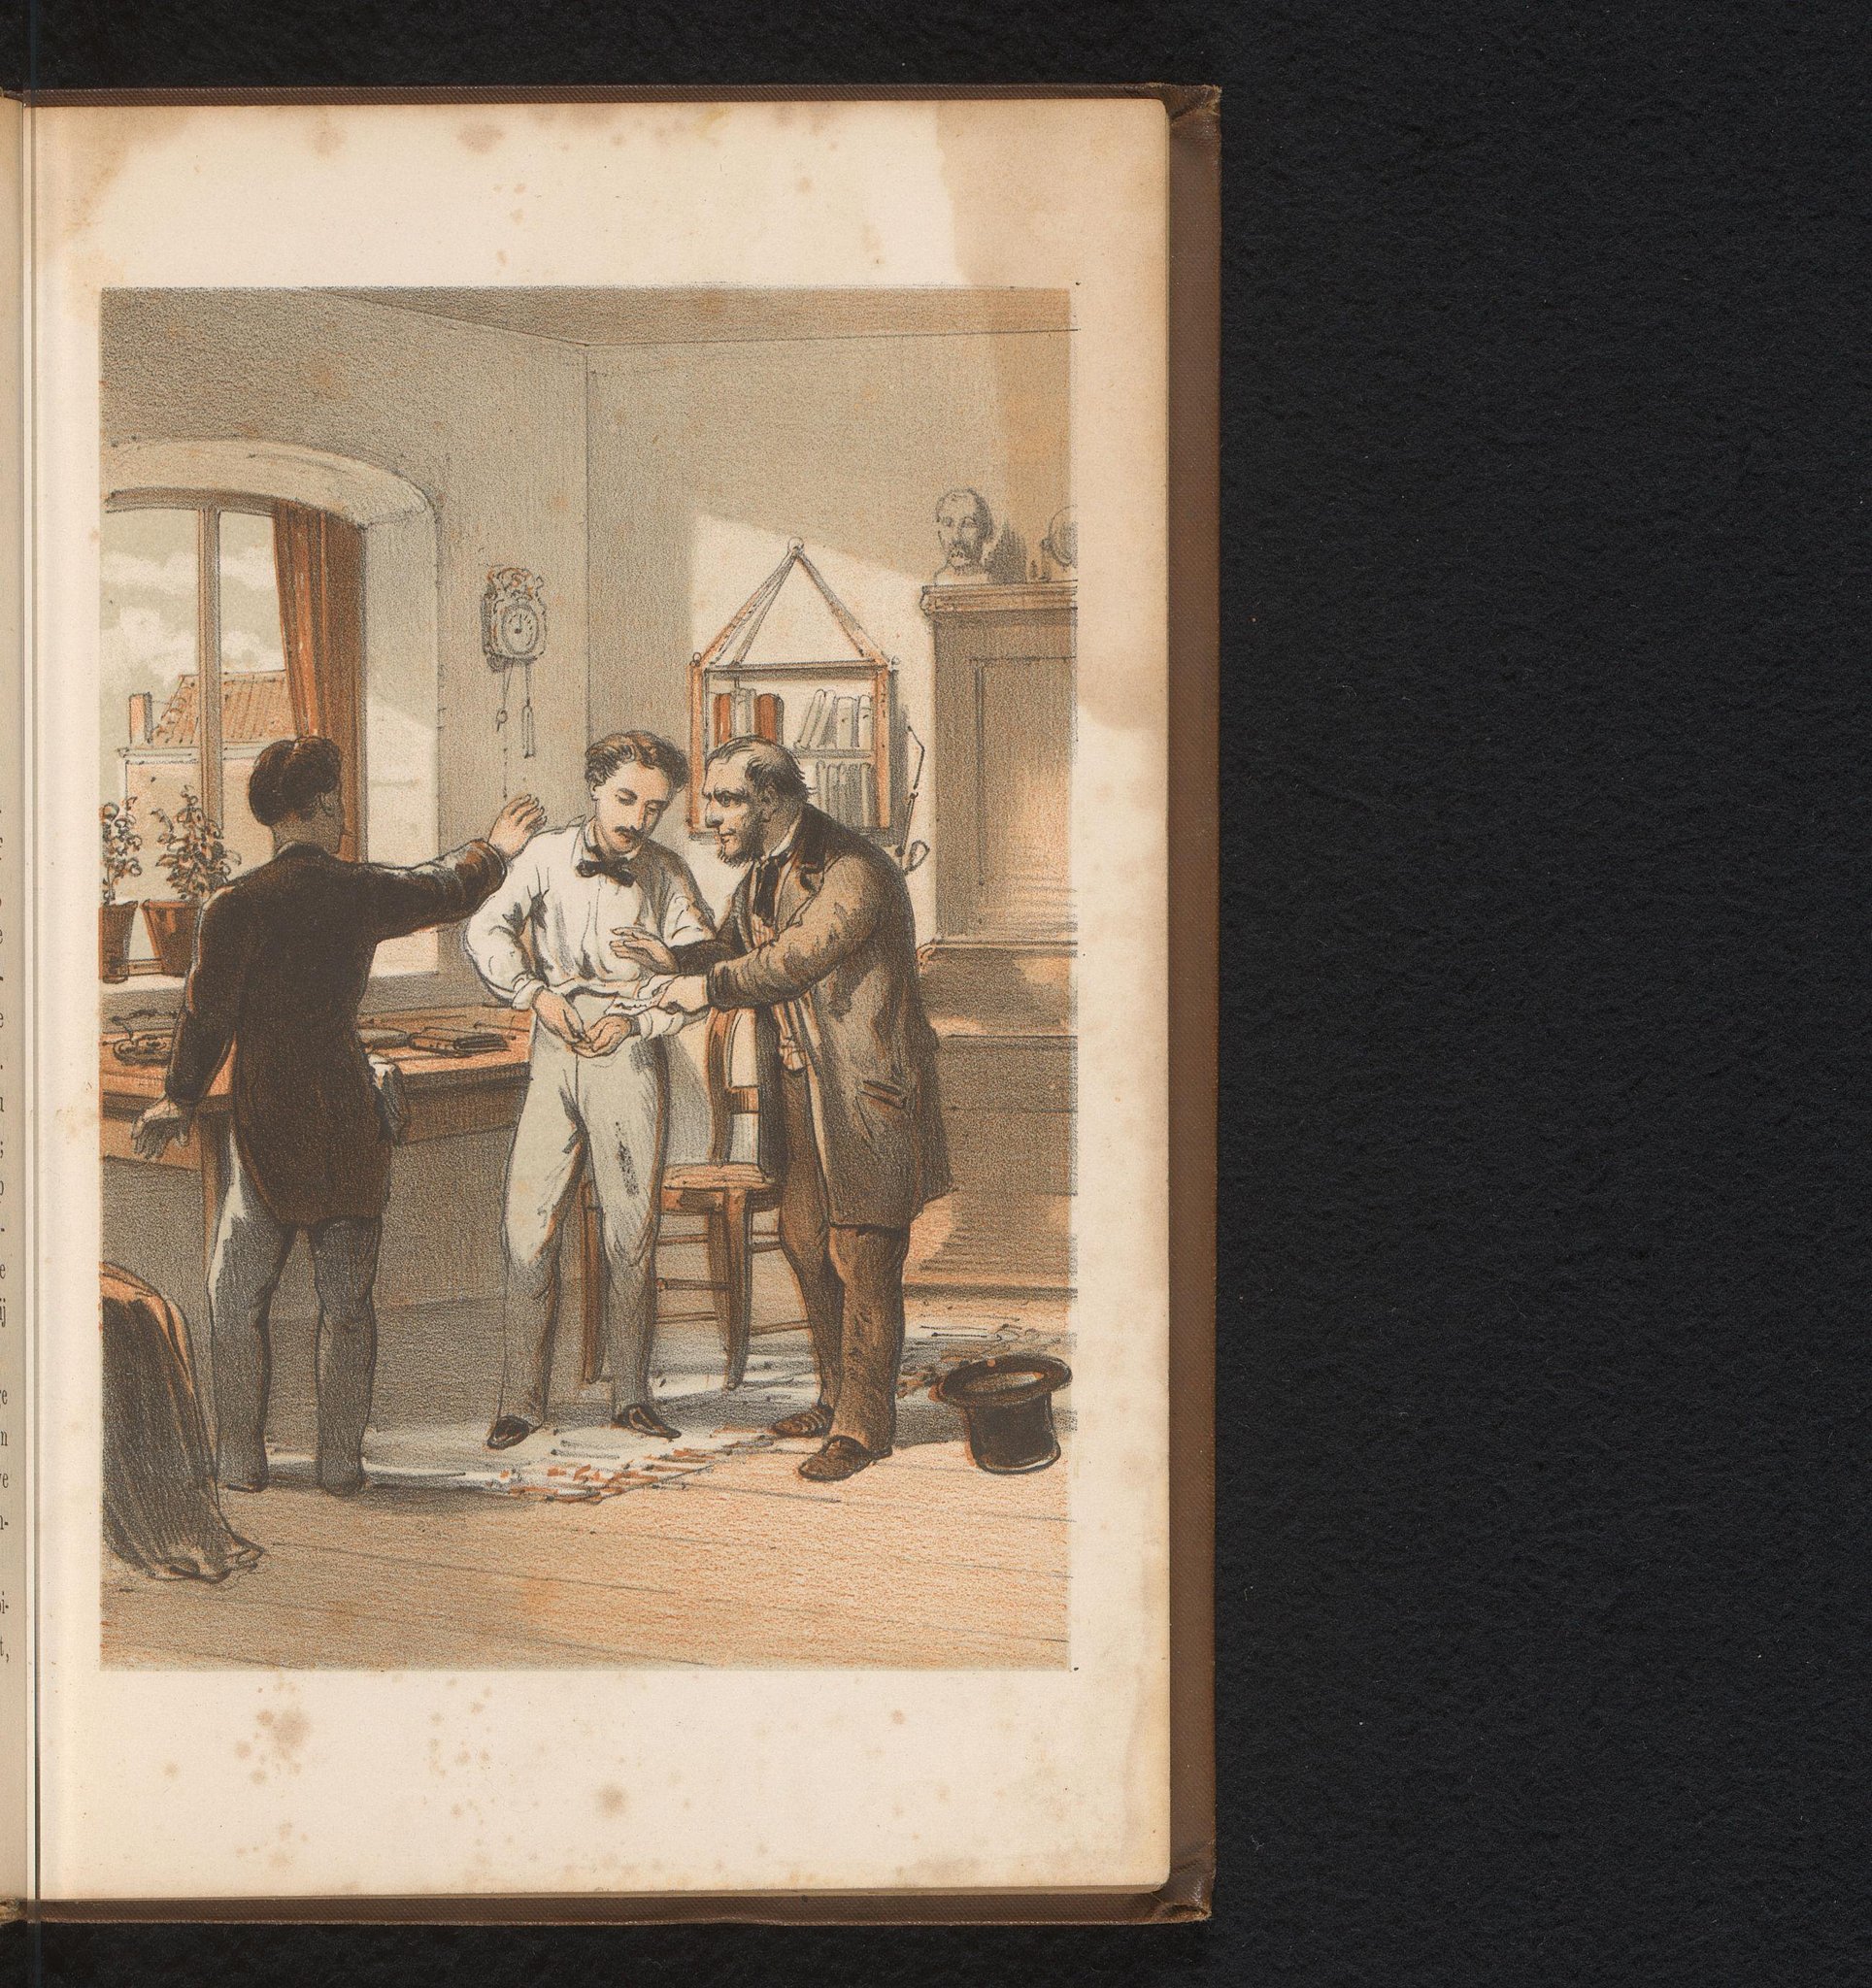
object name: page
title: Twee studenten in gesprek met een lotenverkoper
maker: Anonymous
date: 1860-1865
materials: paper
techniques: lithograph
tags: raffle, lottery, anti-semitism, caricatures (human types), student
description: Prent op ongenummerde pagina tegenover pagina 16.